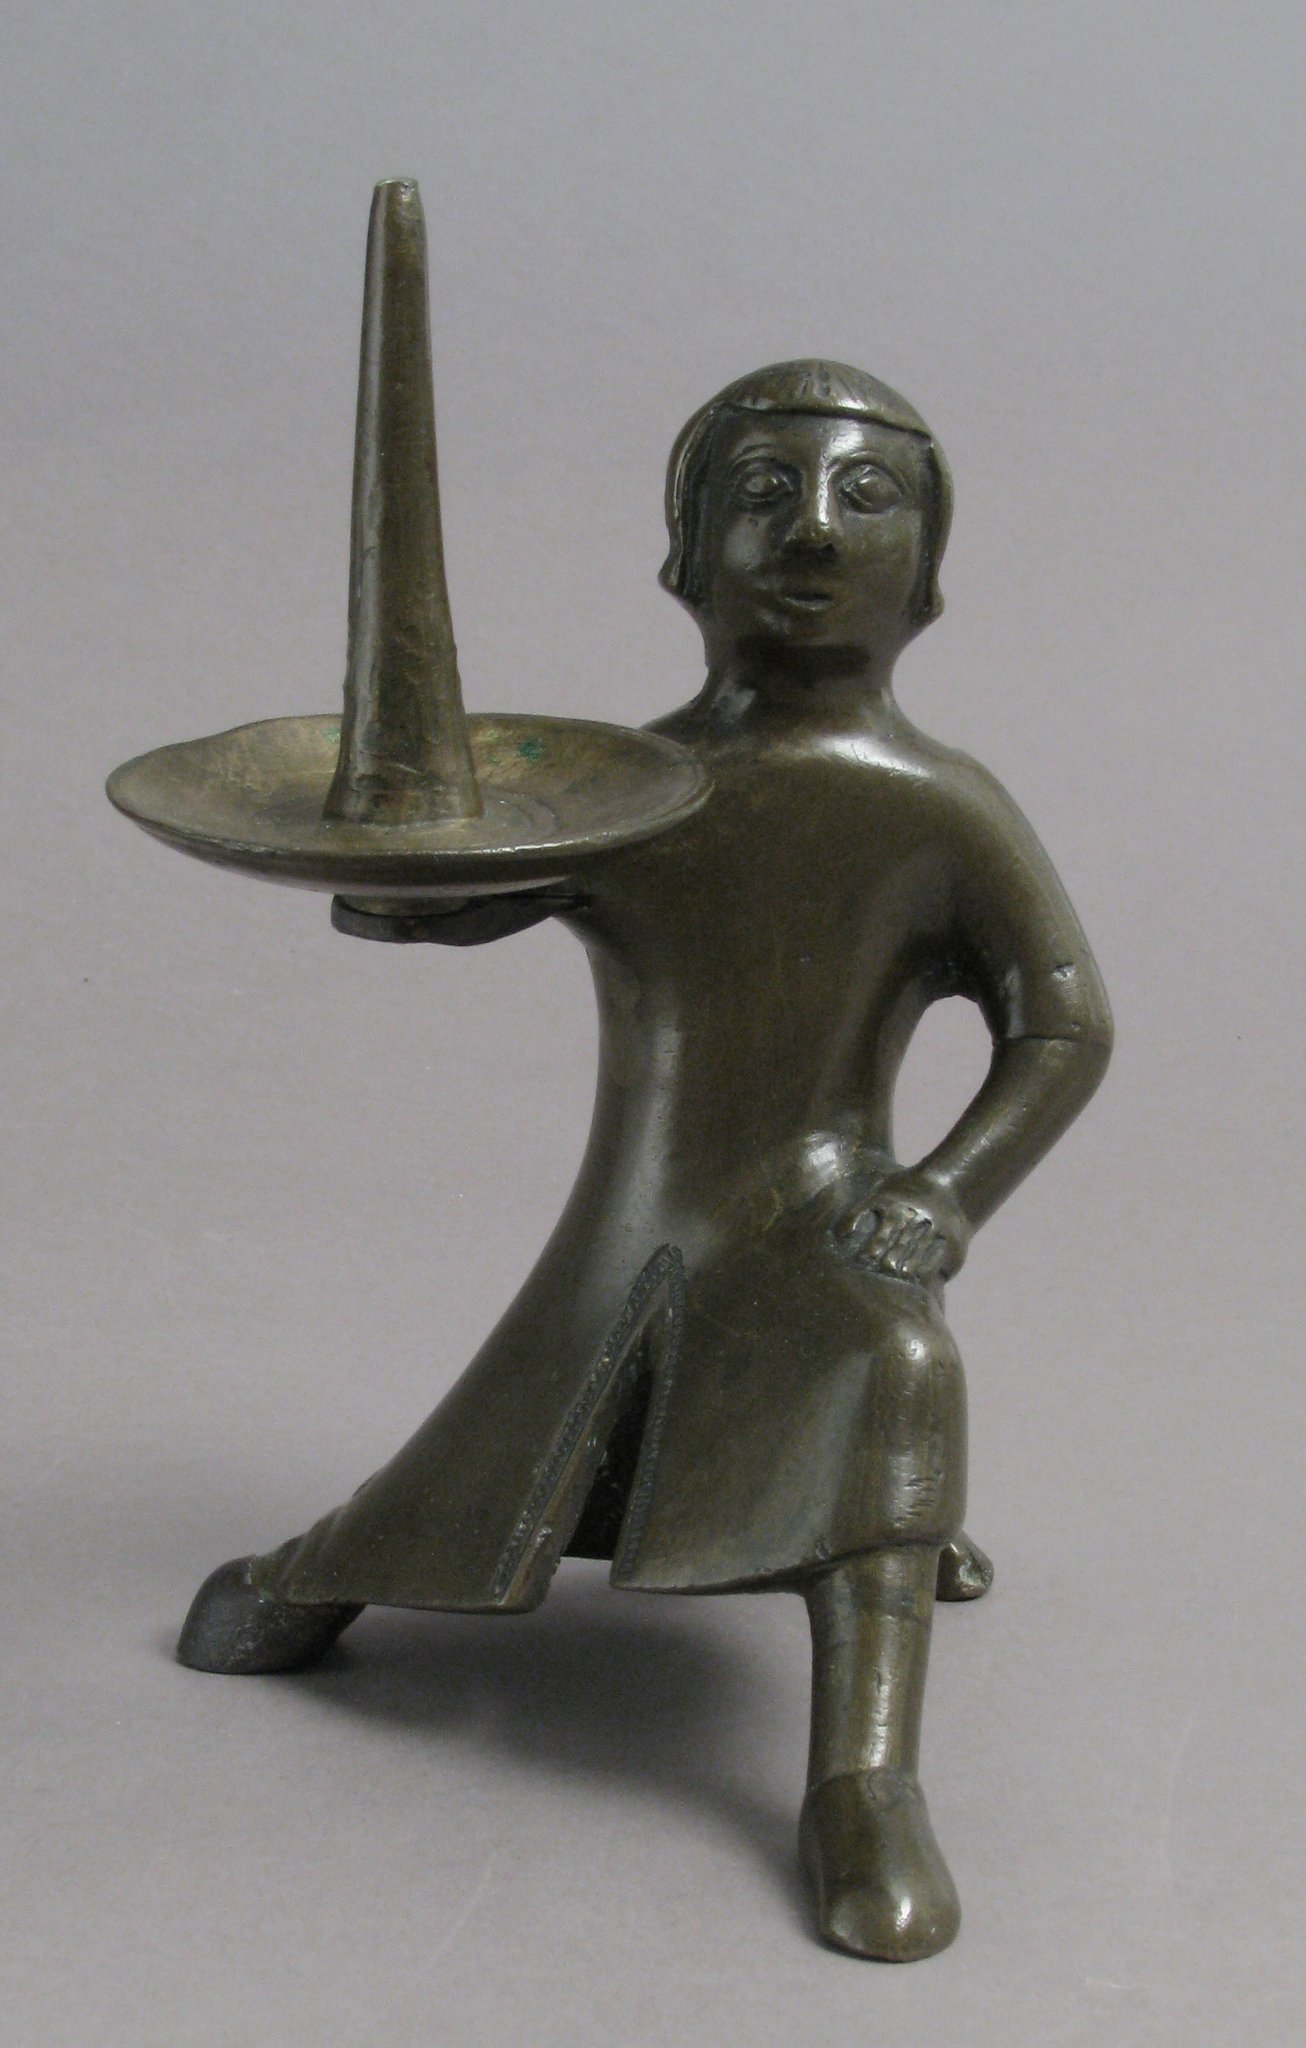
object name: candlestick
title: Pricket Candlestick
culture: south netherlandish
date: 1300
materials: copper alloy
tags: men